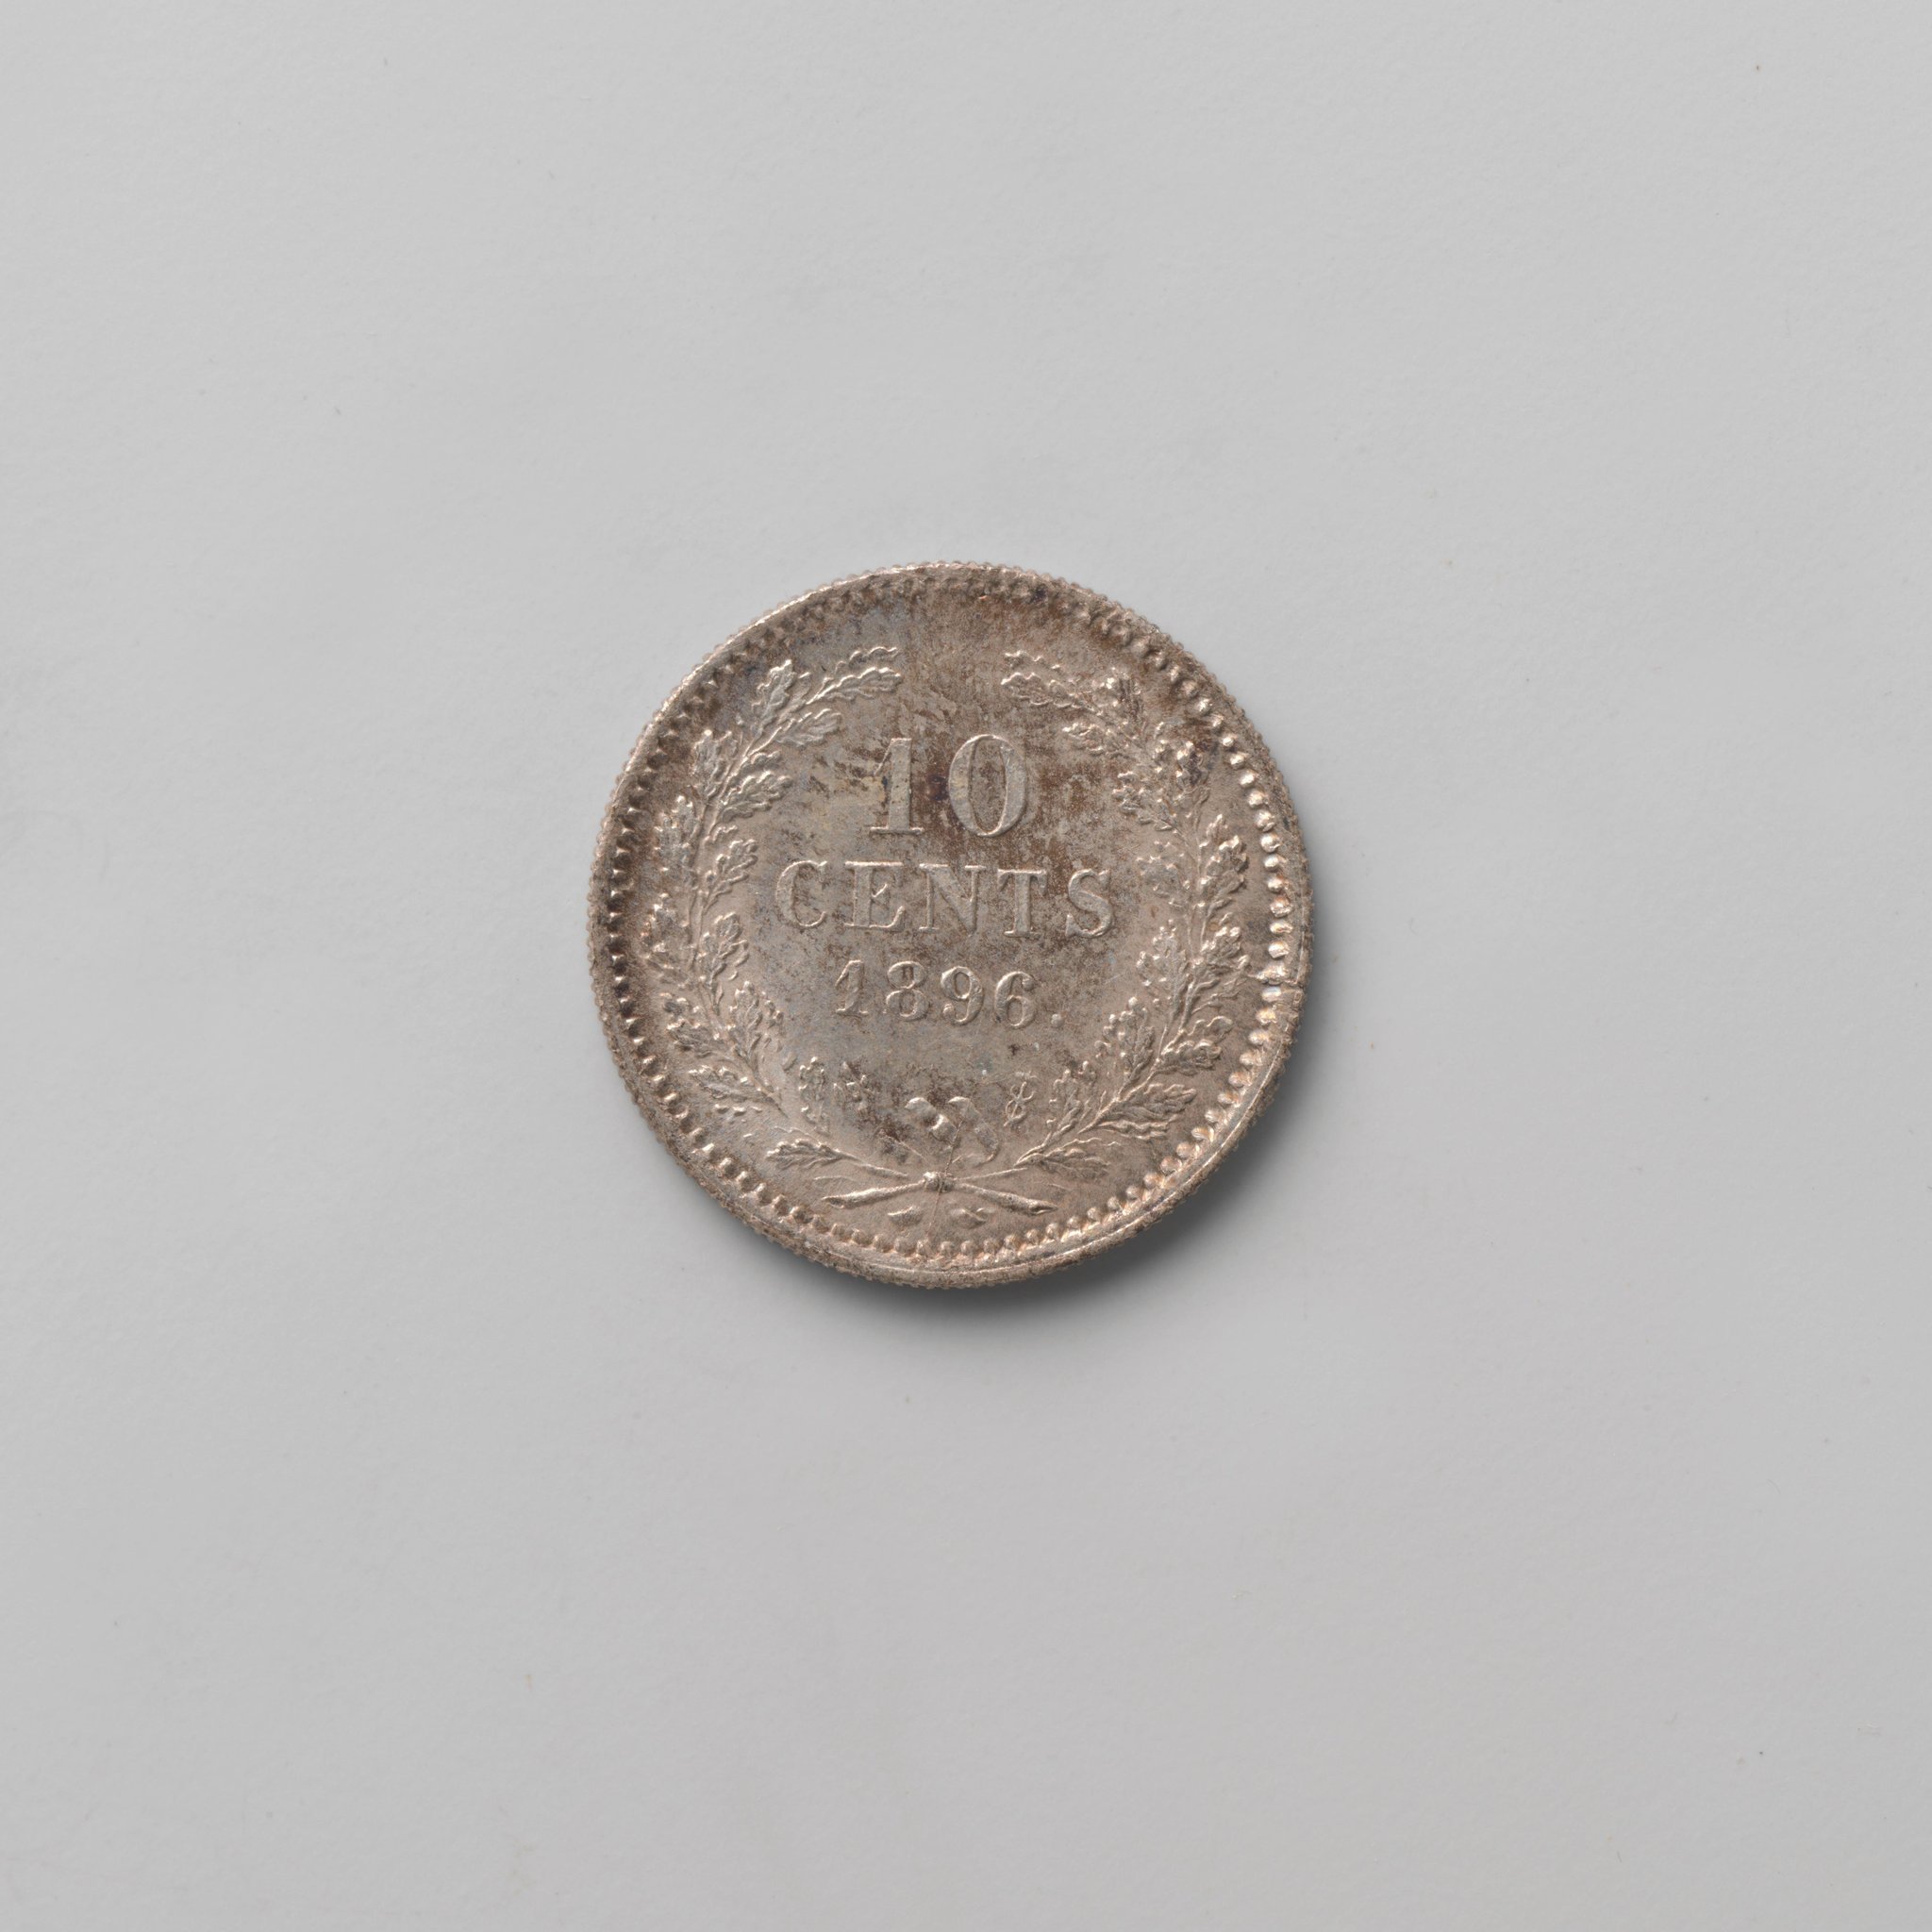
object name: coin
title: Nederlandse 10 cent,1896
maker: wilhelmina of the netherlands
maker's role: print maker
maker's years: 1880-1962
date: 1896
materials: silver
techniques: striking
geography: utrecht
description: Zilveren munt. Voorzijde: jeugdig borstbeeld naar links. Keerzijde: binnen twee samengebonden eiketakken waarde-aanduiding 10 cents en jaartal. Kartelrand.